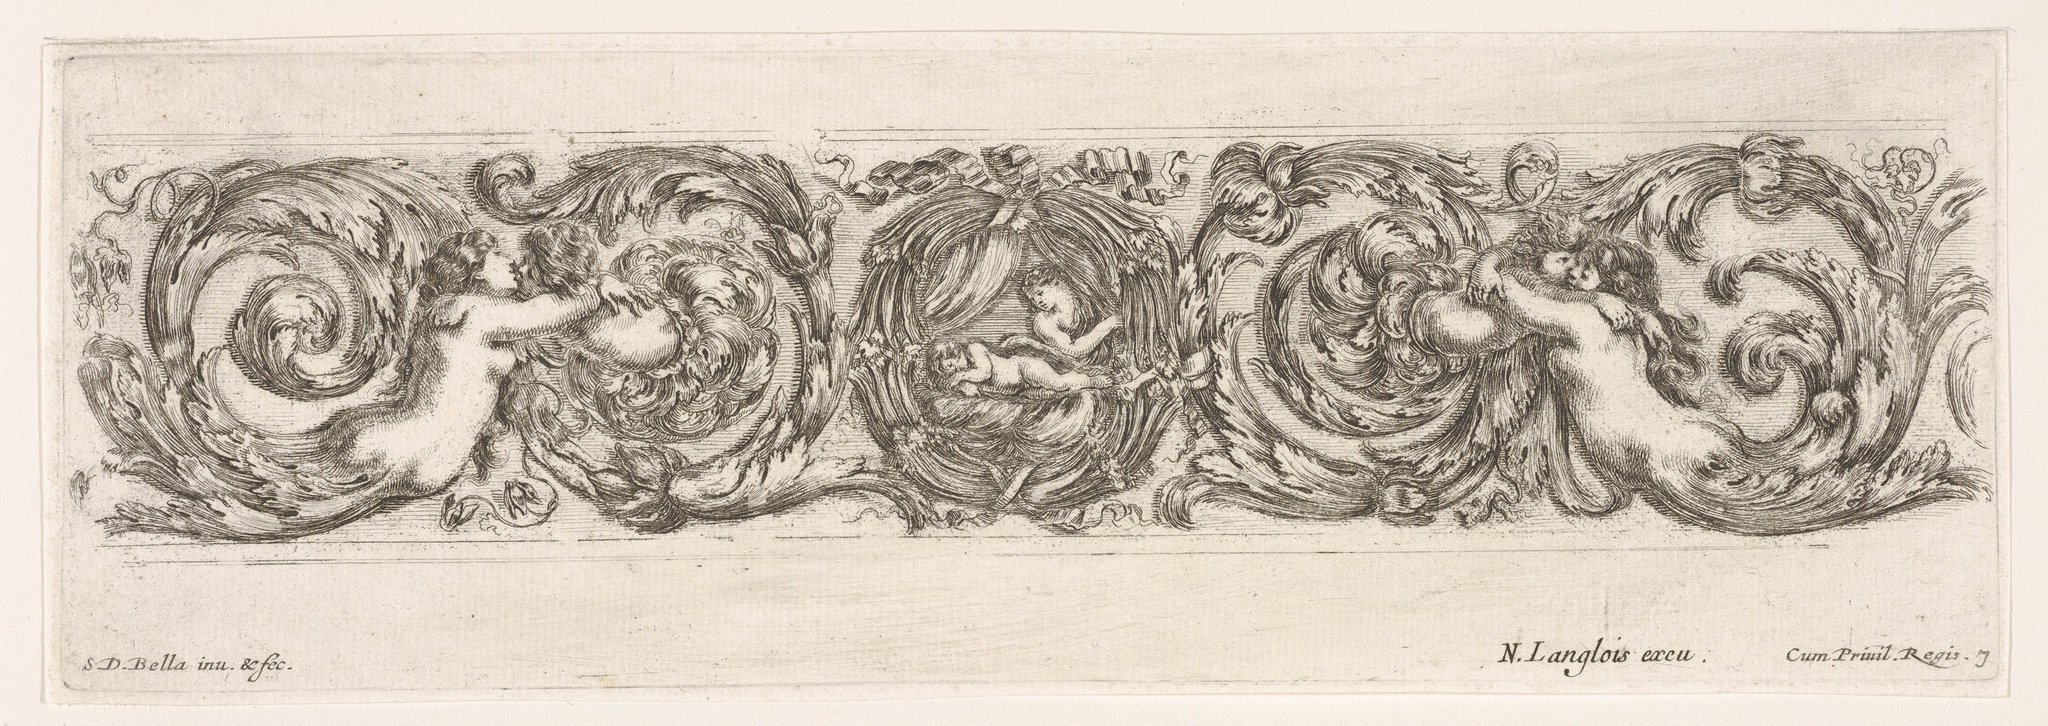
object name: print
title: Design for a Frieze with Acanthus Scrolls with the Theme of Love, plate 7 from "Decorative friezes and foliage" (Ornamenti di fregi e fogliami)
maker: stefano della bella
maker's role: artist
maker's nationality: italian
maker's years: 1610-1664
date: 1645-1650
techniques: etching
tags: ornament,children,female nudes,acanthus